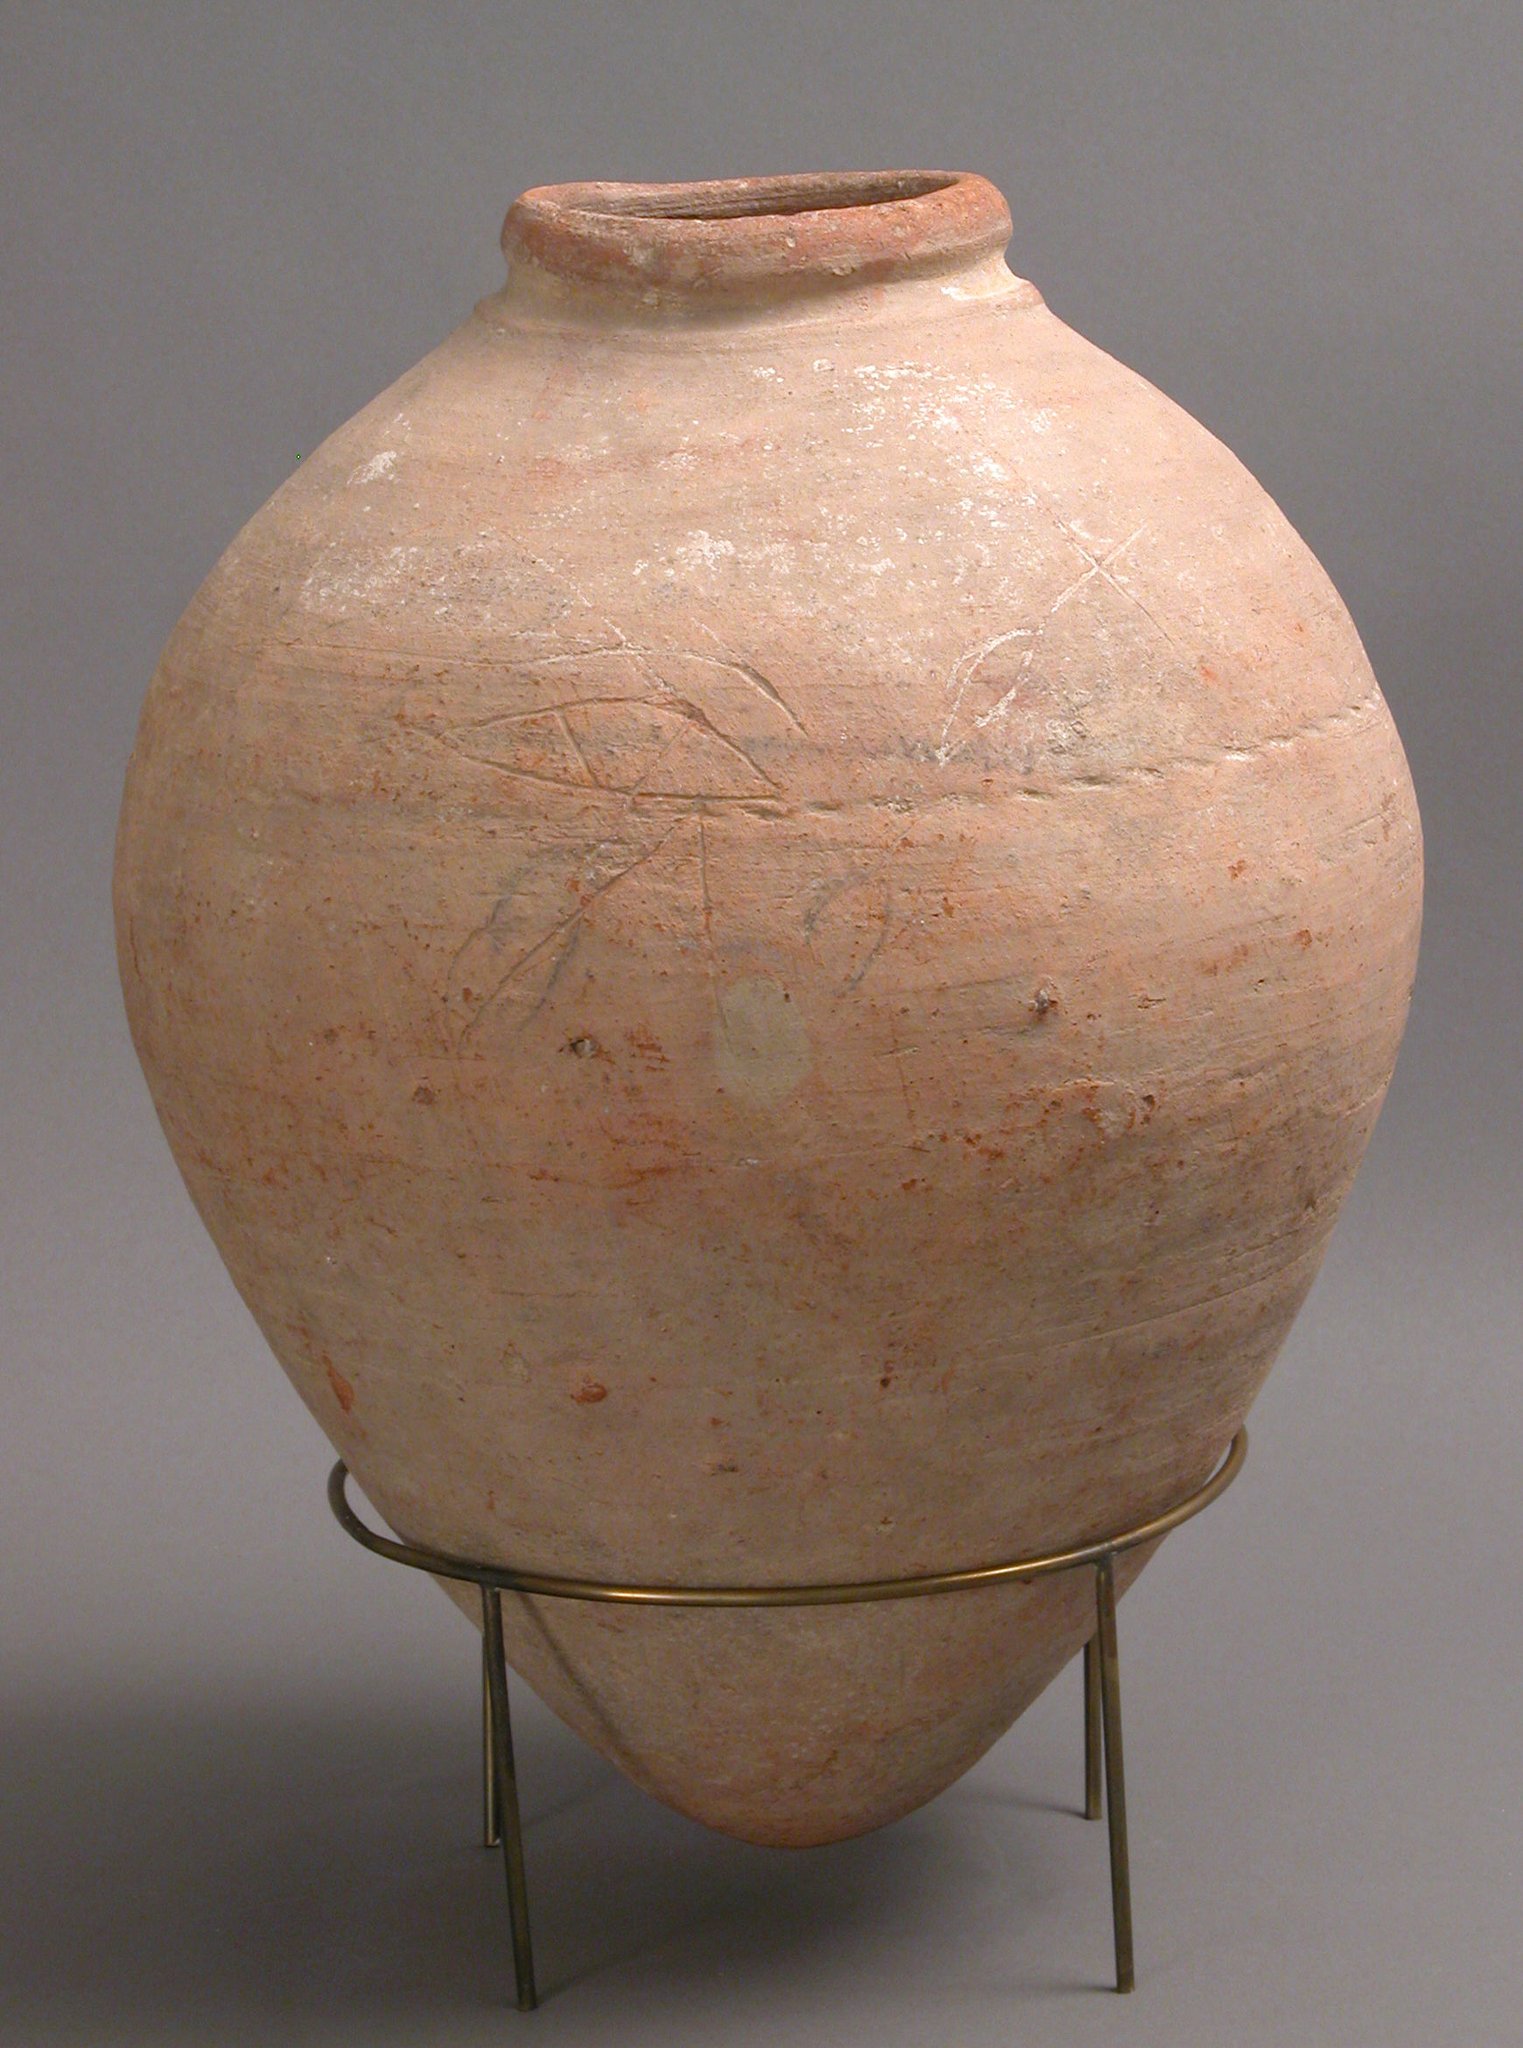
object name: jar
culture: coptic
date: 301-700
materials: earthenware, fiber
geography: egypt